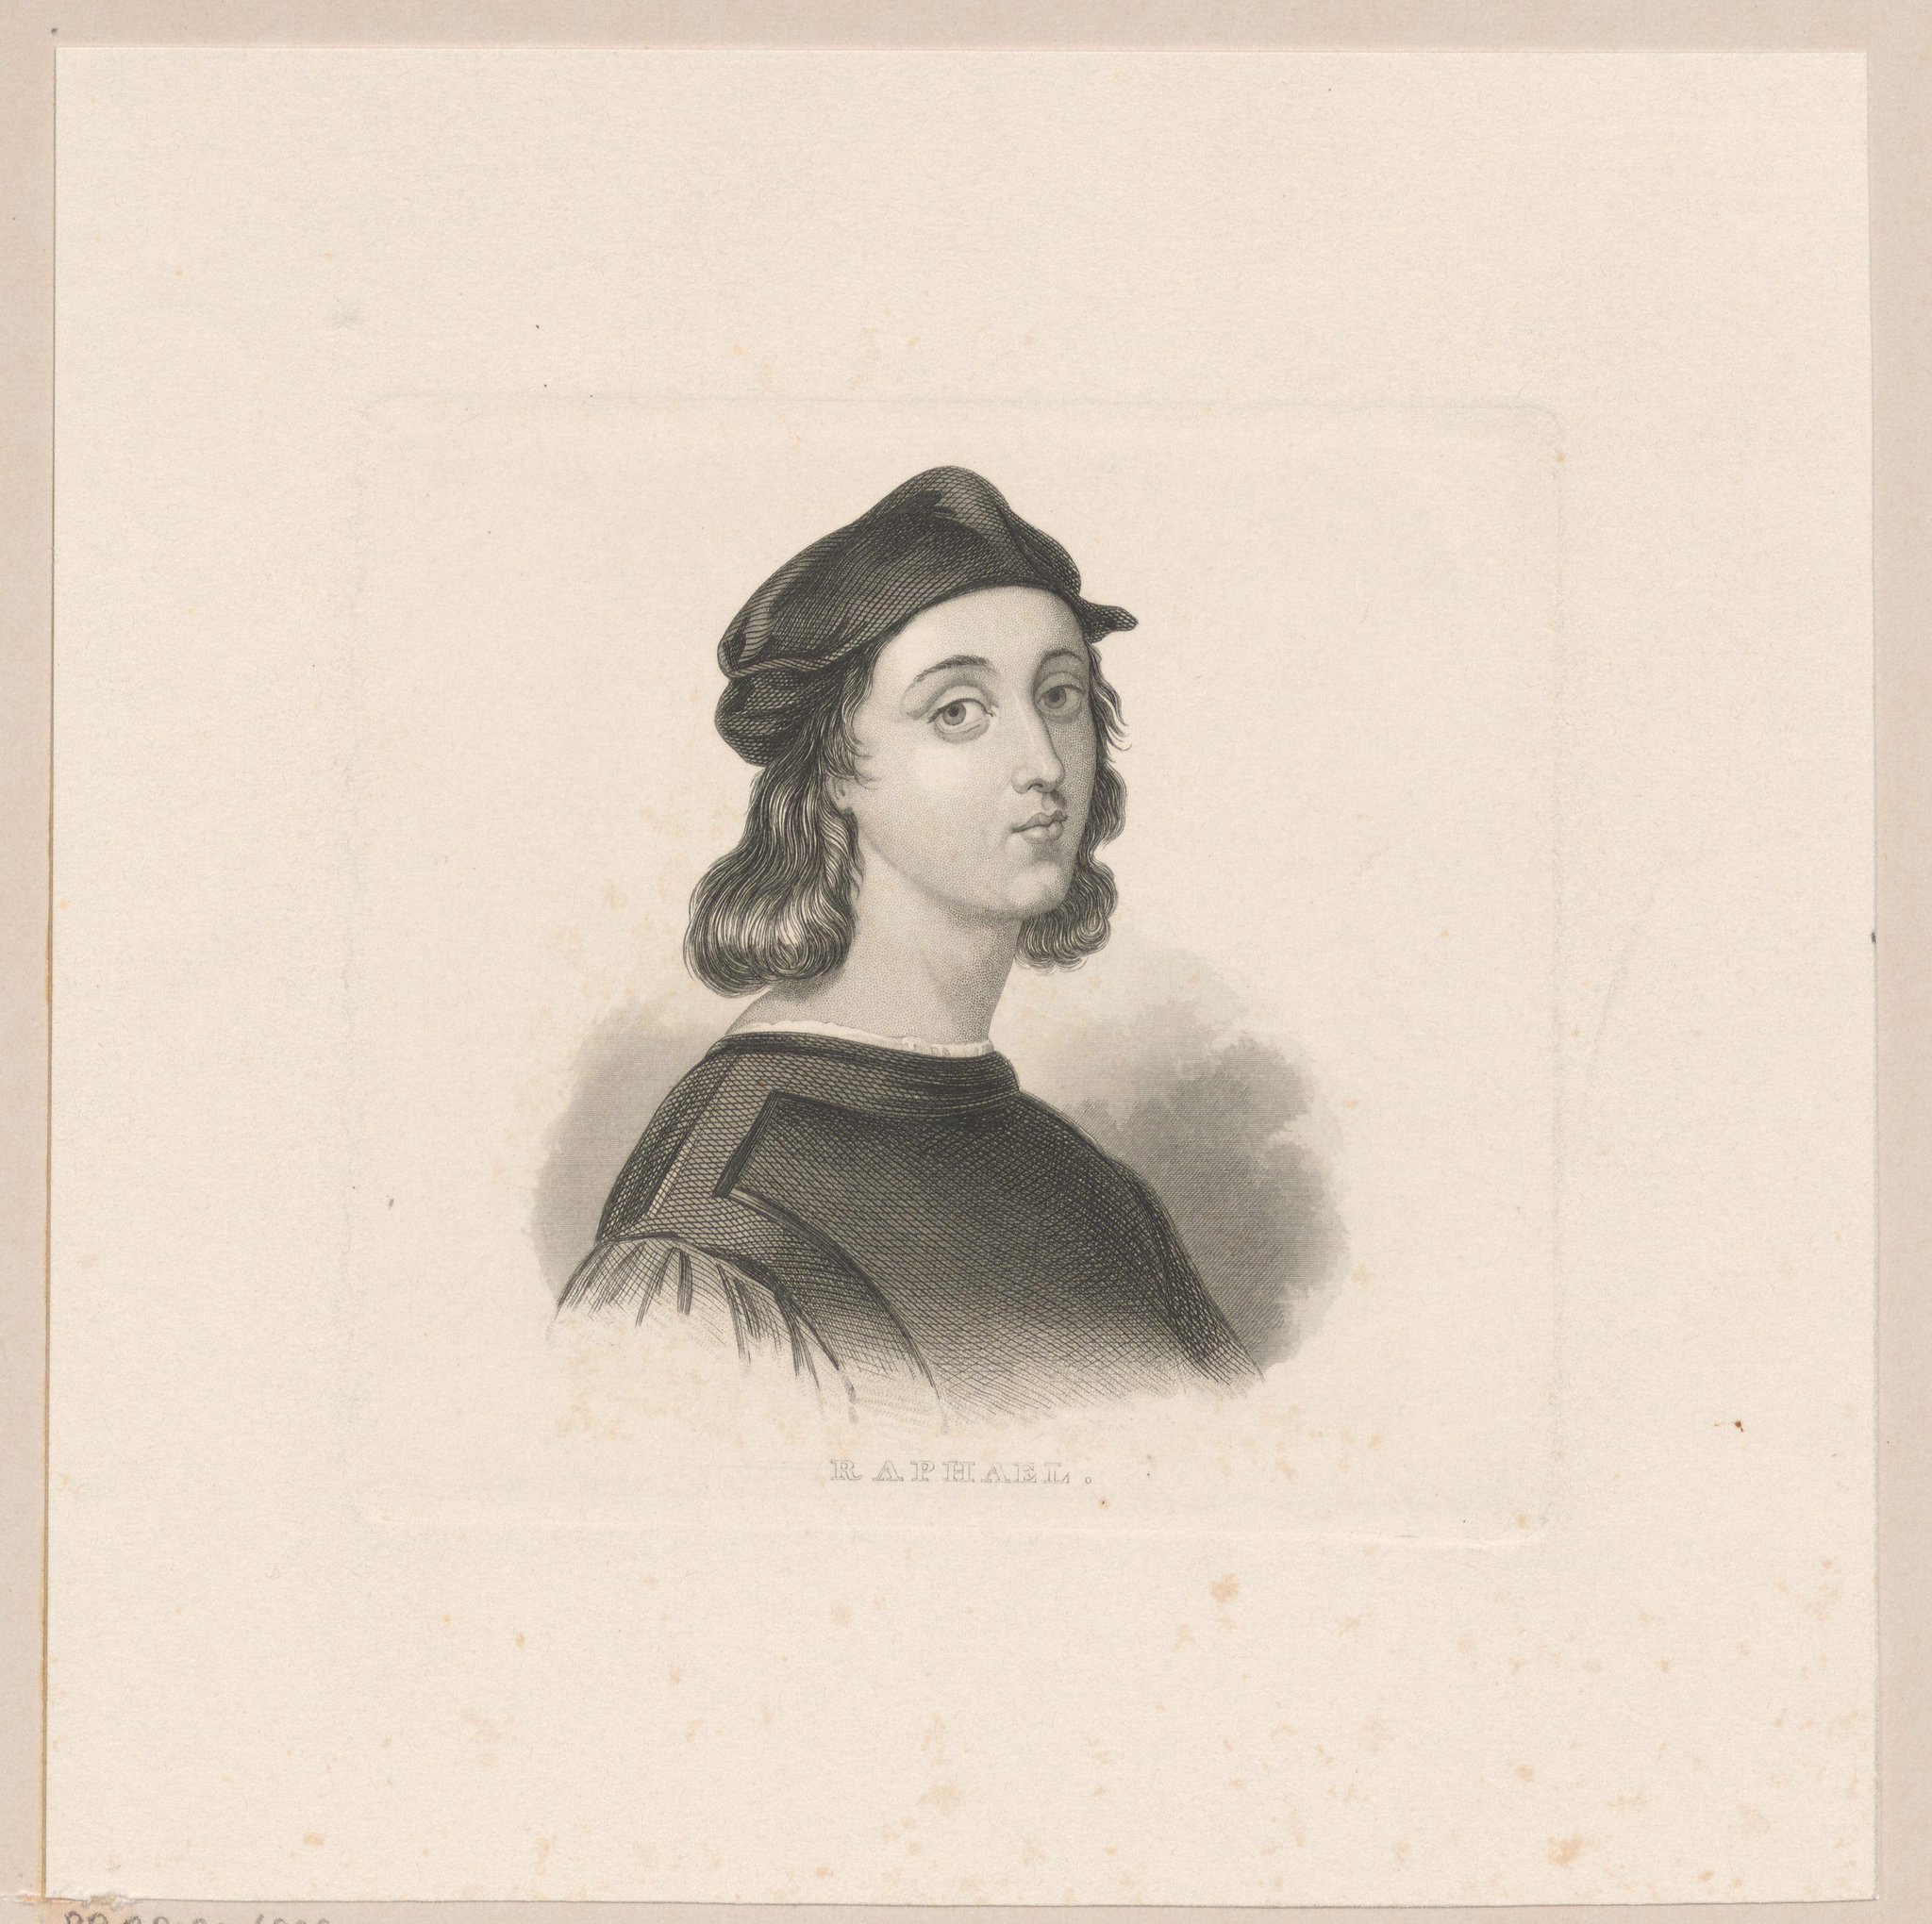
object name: print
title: Portret van Rafaël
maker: Anonymous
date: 1800-1899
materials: paper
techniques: engraving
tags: rome, painter, rafaël, historical persons, portrait, self-portrait of painter